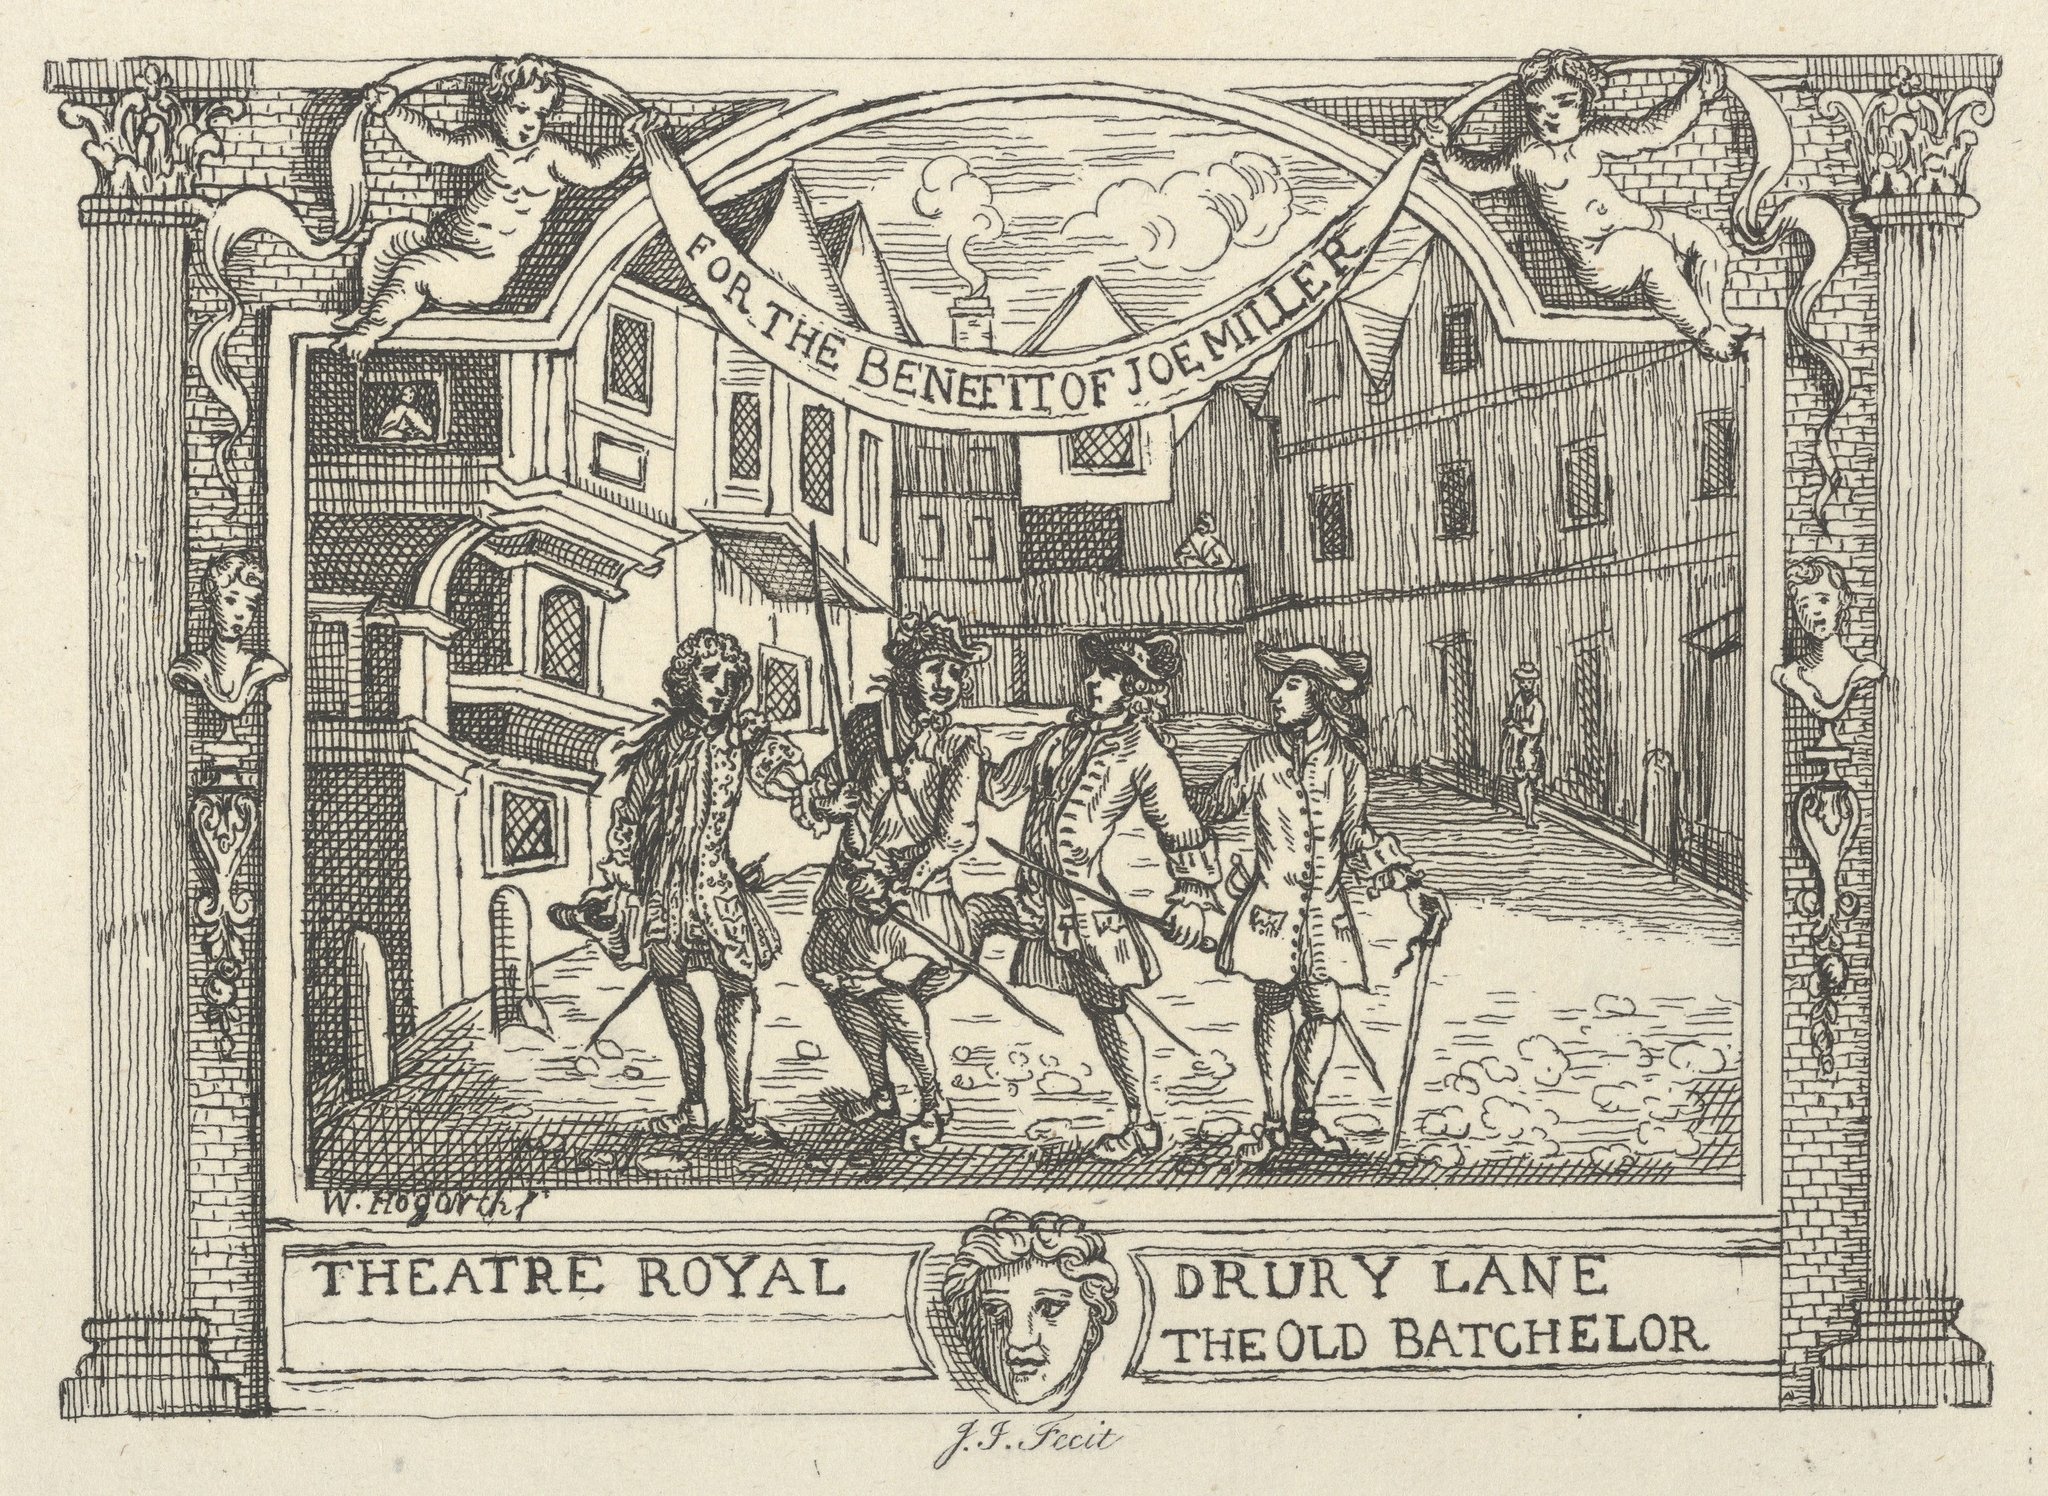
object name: print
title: Benefit Ticket for Joe Miller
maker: samuel ireland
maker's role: etcher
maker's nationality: british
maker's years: 1700-1800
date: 1794-1799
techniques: etching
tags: buildings,men